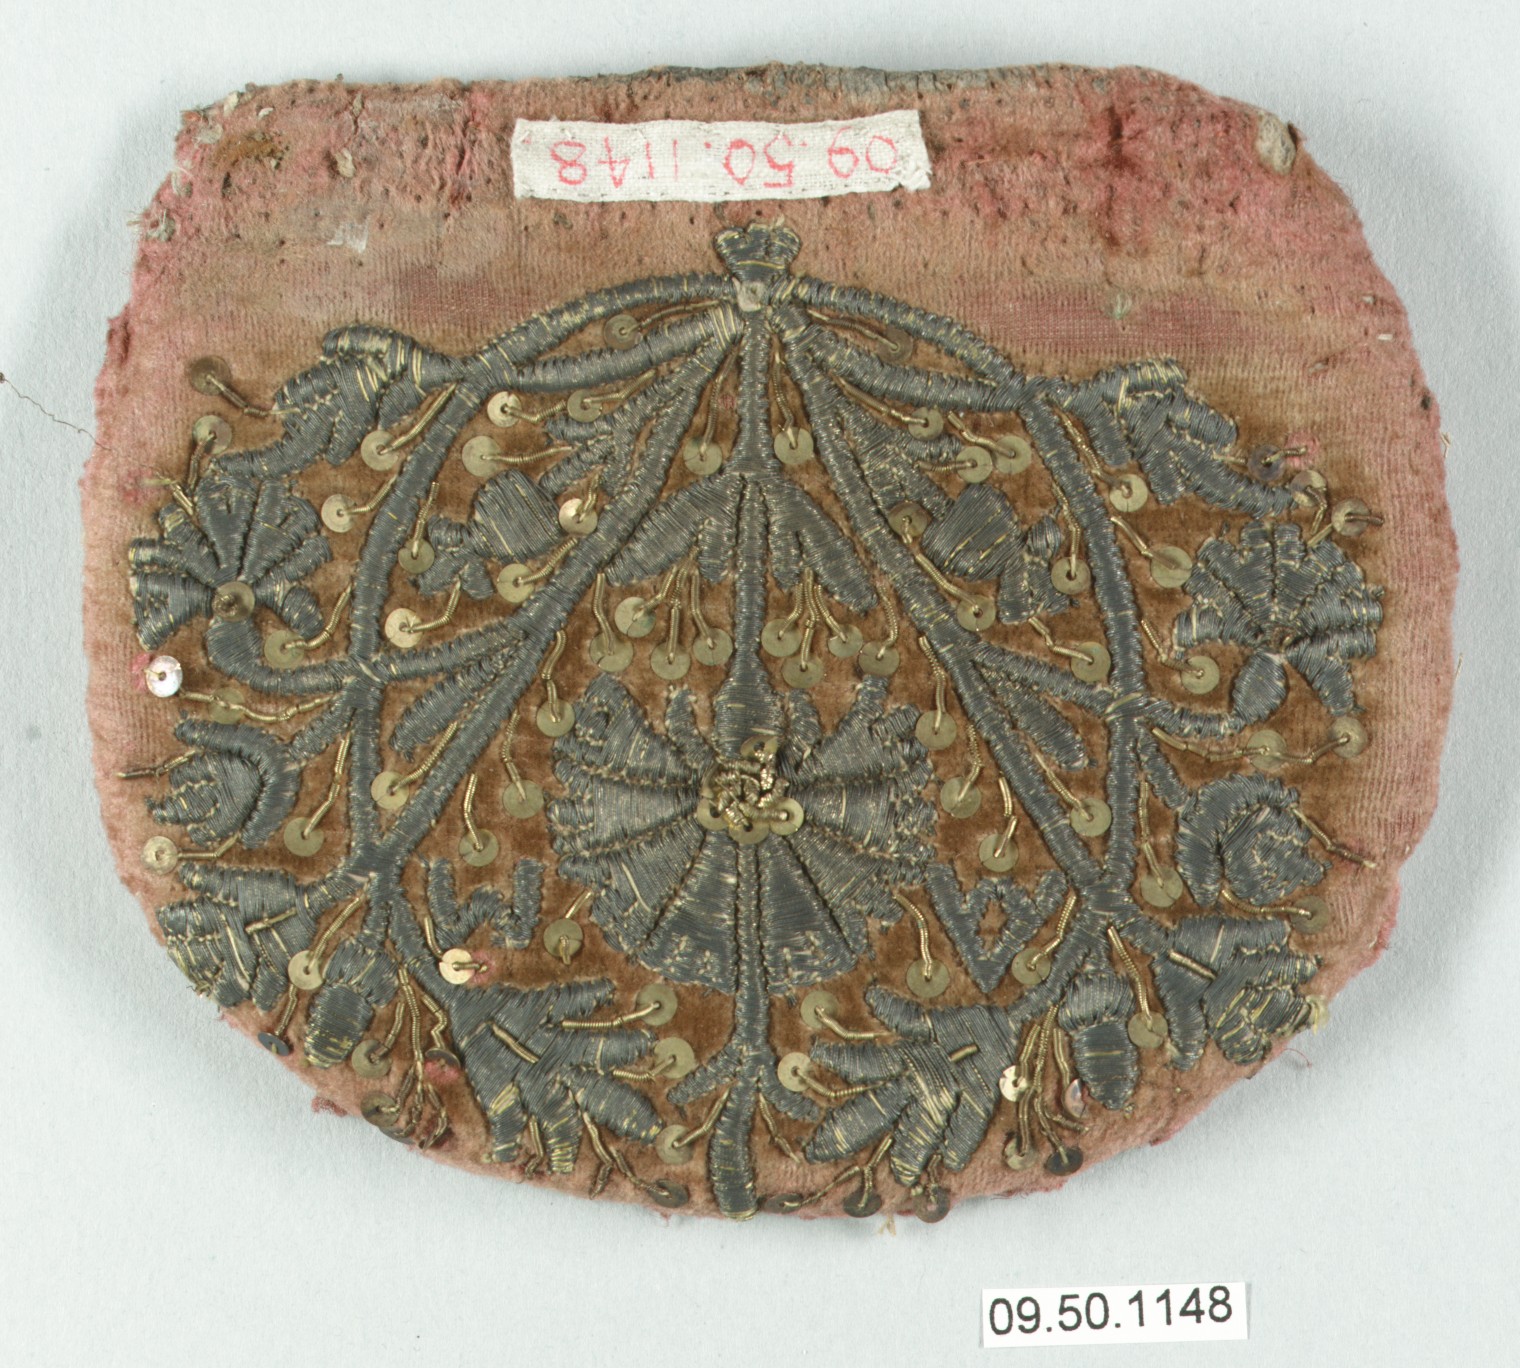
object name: cap crown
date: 1701-1800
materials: metal thread, velvet